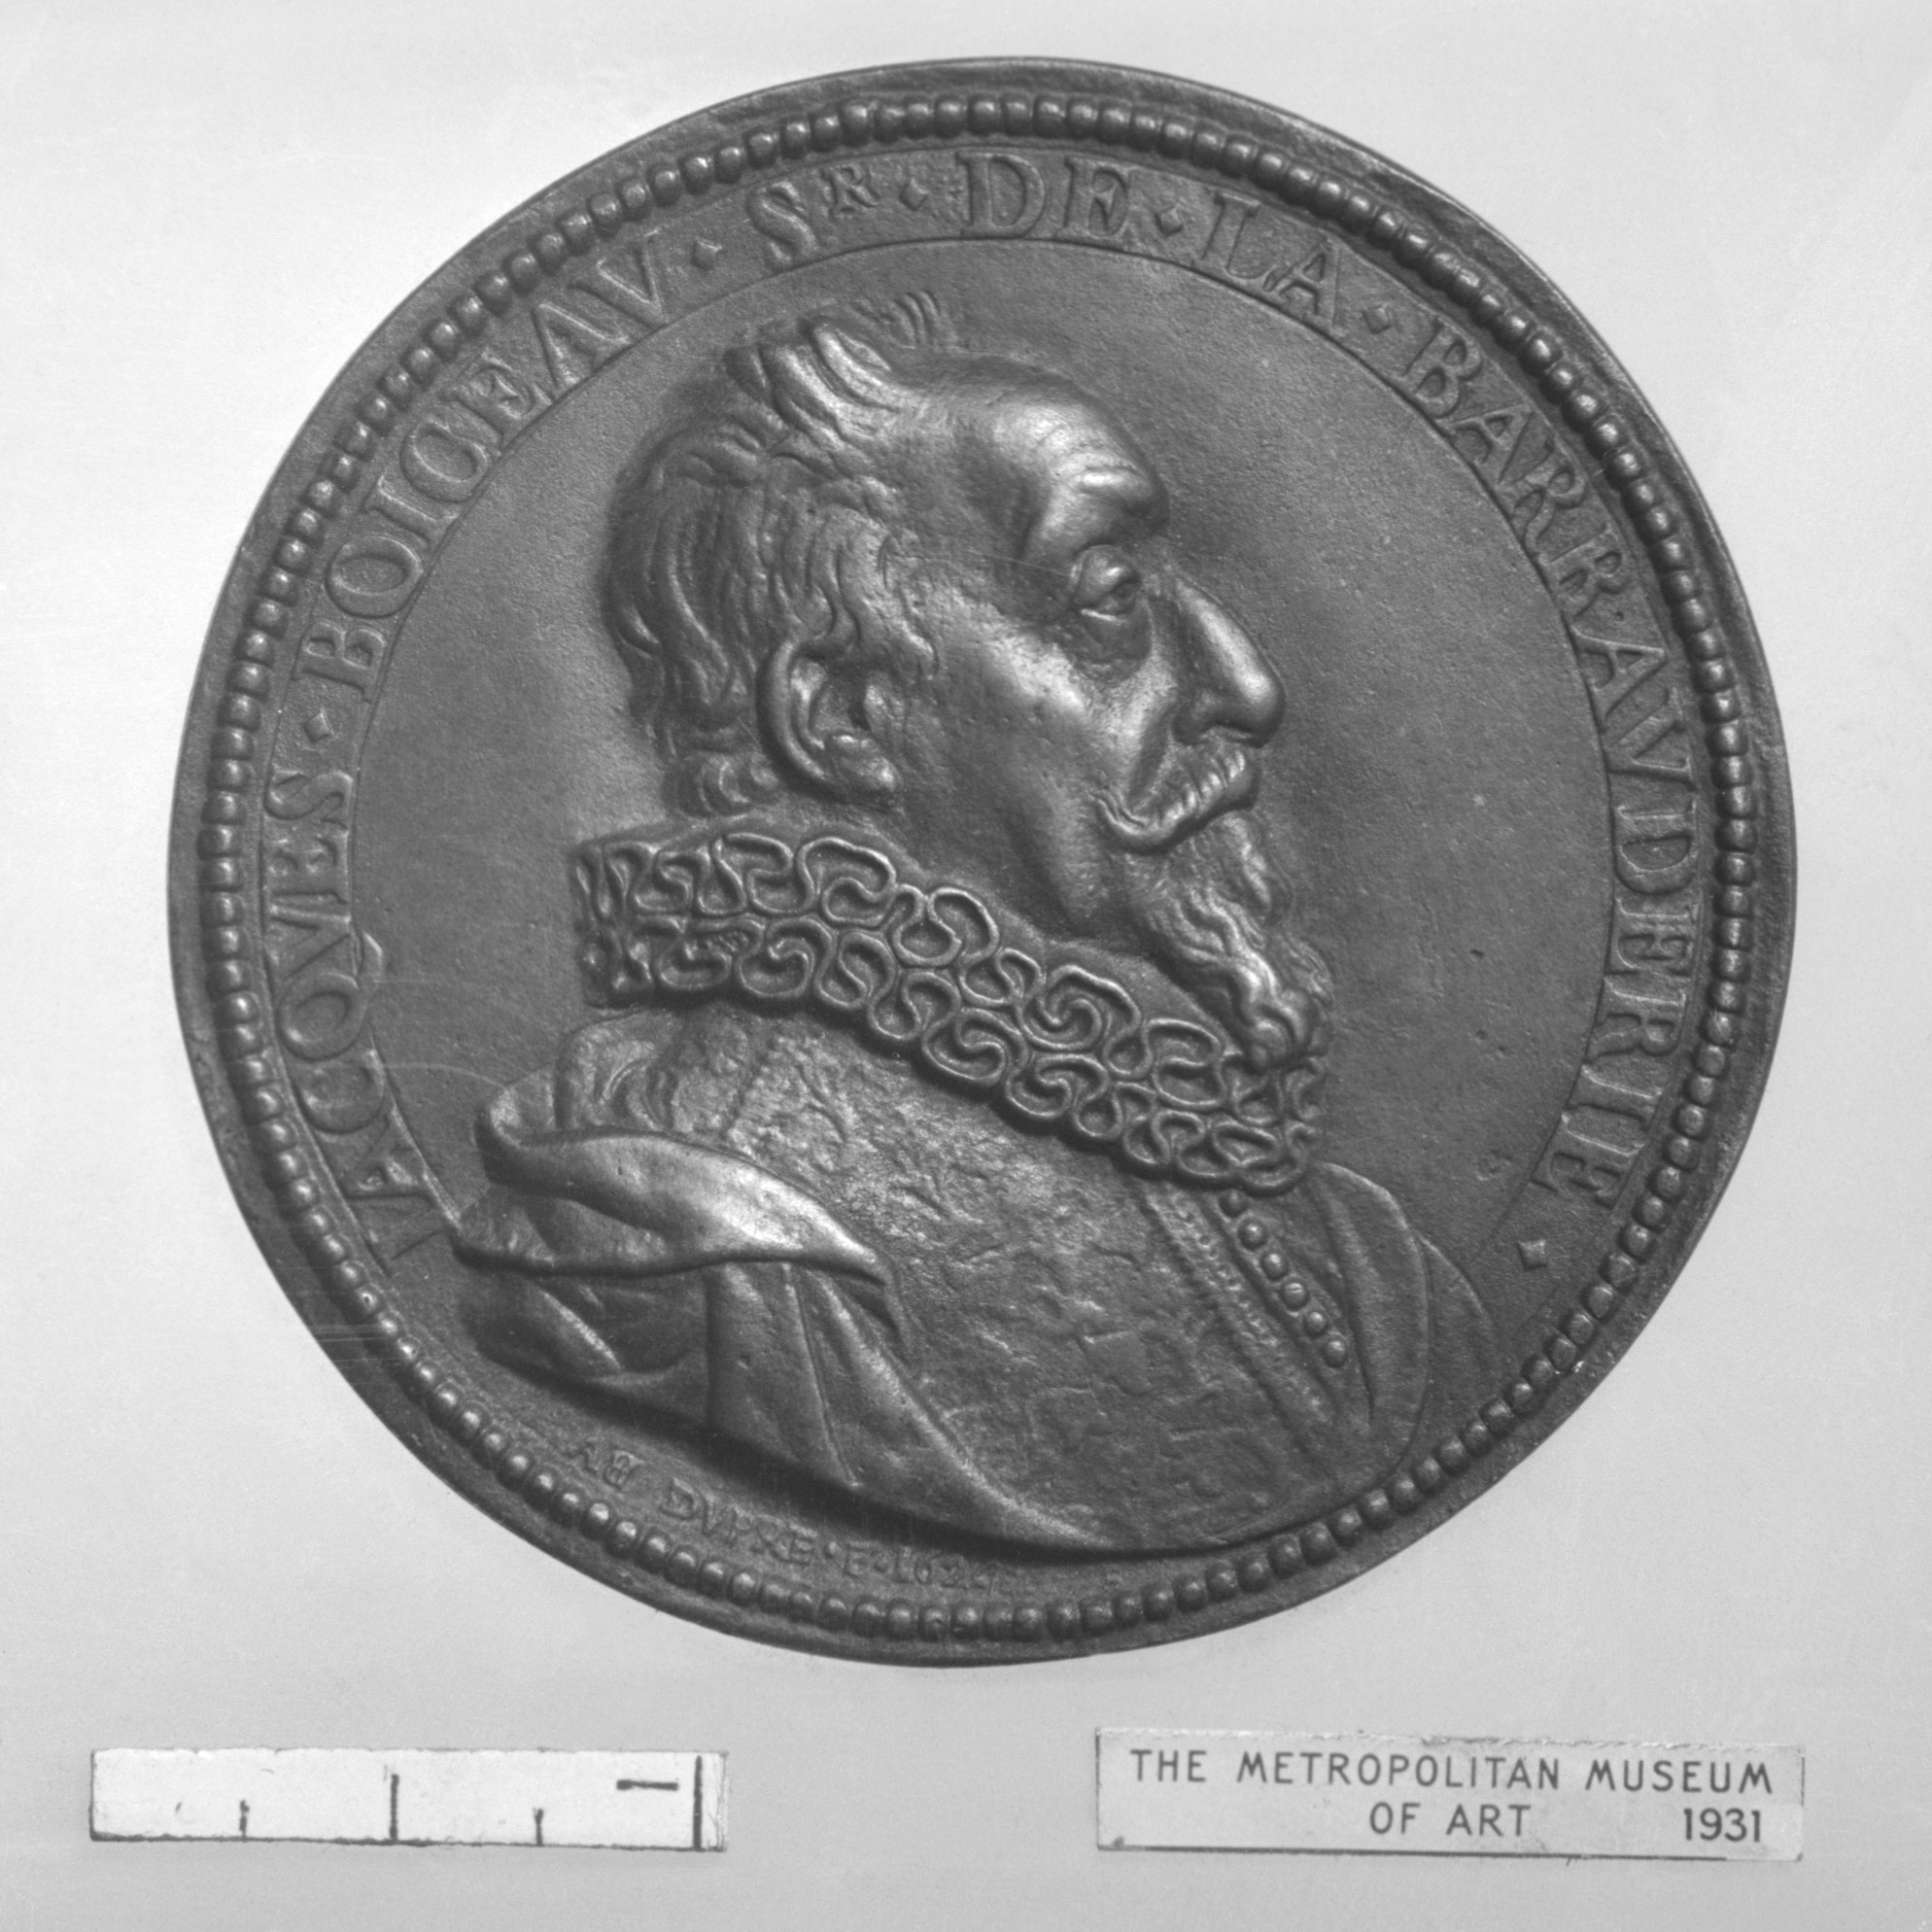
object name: medal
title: Jacques Boiceau, Seigneur de la Barauderie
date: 1601-1700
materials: bronze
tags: men,profiles,butterflies